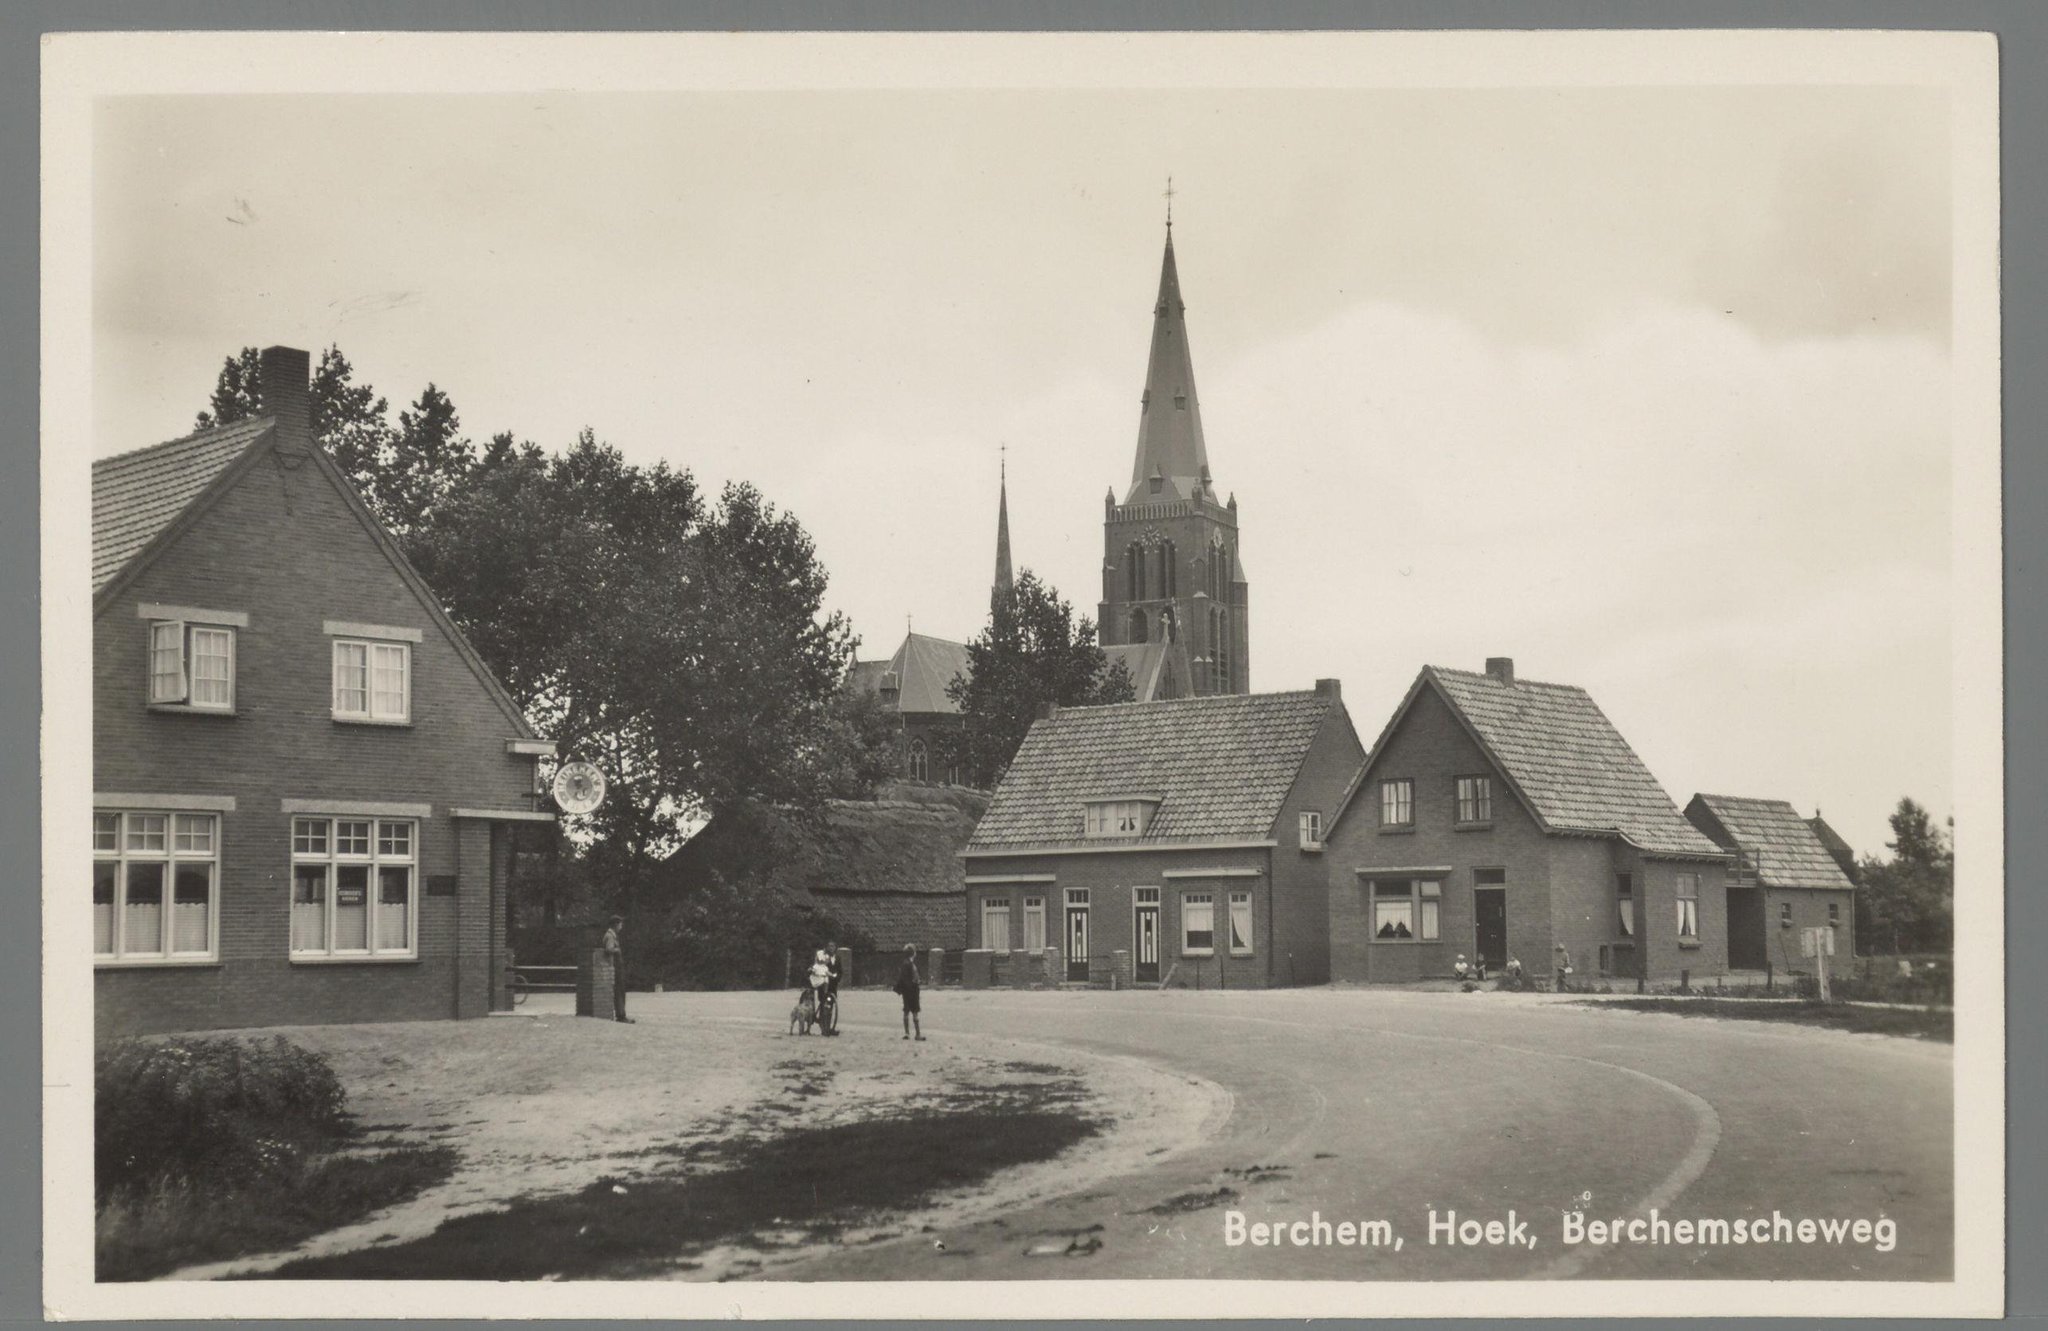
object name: ansichtkaart, prentbriefkaart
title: Berchem, Hoek, Berchemscheweg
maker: Anonymous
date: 1908-1940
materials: paper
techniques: gelatin silver print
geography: berchem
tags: city-view, and landscape with man-made constructions, church (exterior)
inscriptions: date